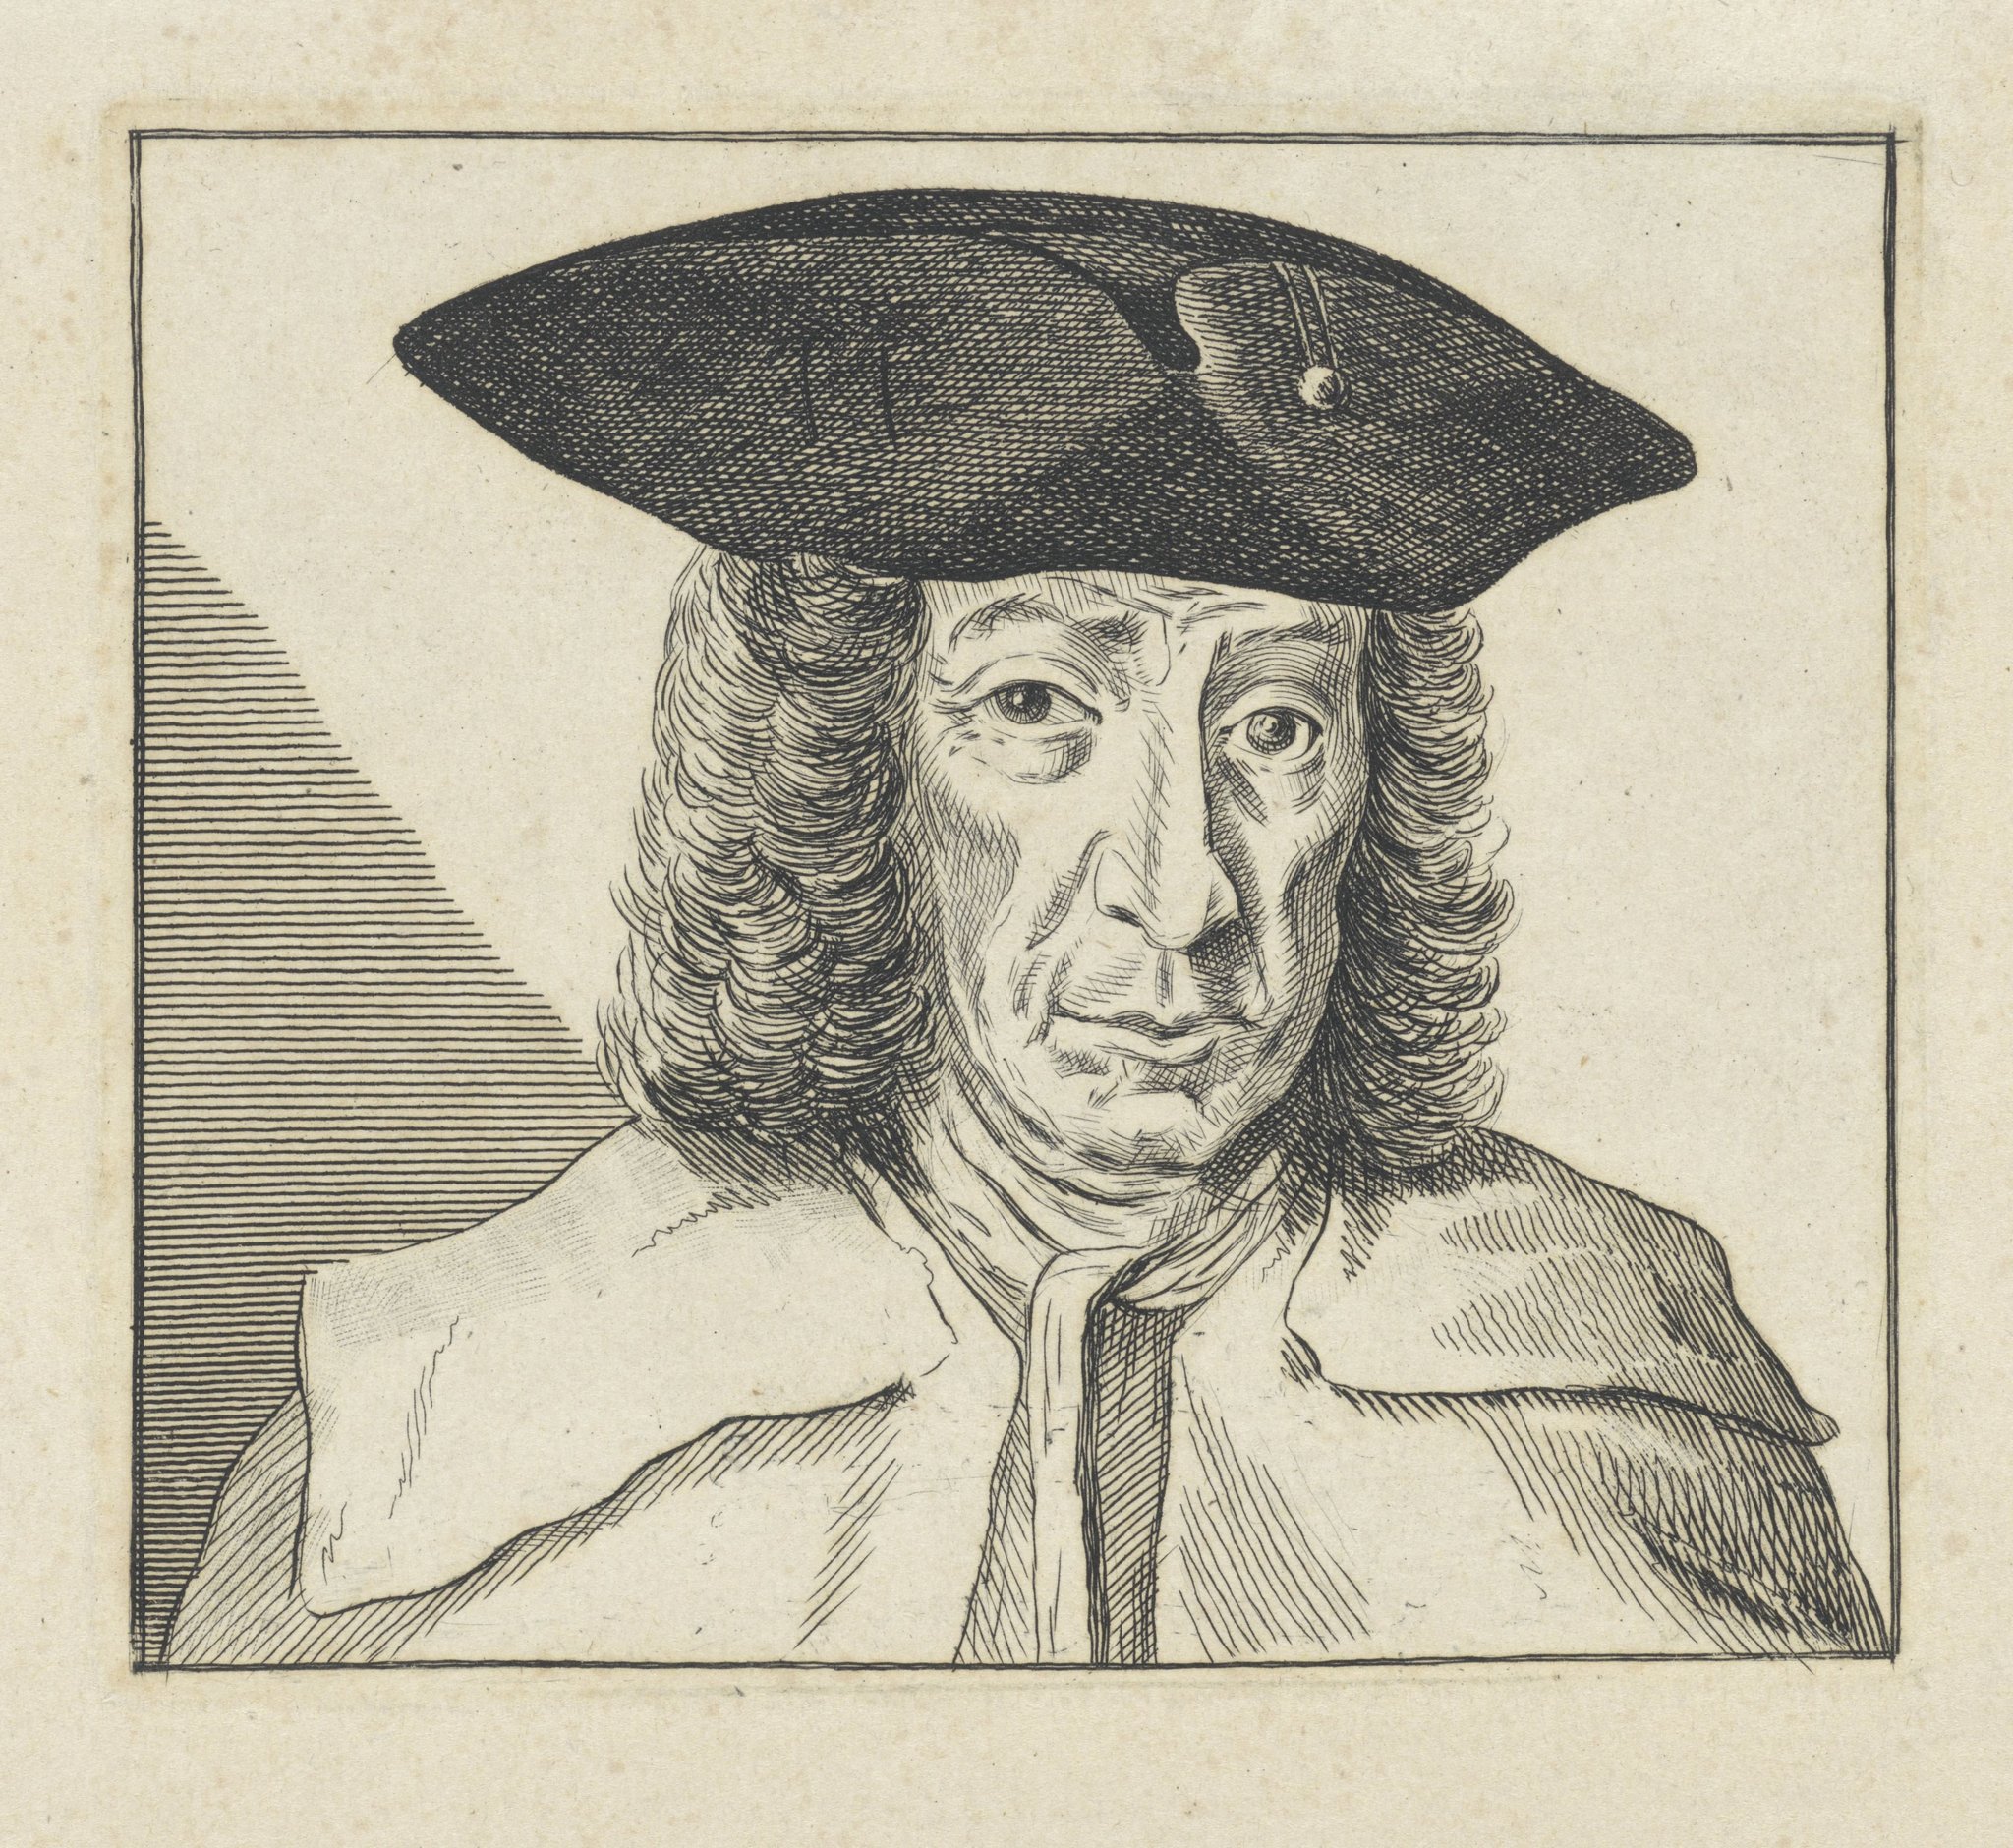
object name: print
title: Portret van Cavallero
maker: reinier vinkeles (i)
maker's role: draughtsman, print maker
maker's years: 1741-1816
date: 1750-1765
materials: paper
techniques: etching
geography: amsterdam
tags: amsterdam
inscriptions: collector's mark: Lugt 2228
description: Portret van Cavallero, een honderdjarige Portugees Joodse verkoper van snuisterijen op de Amsterdamse beurs.